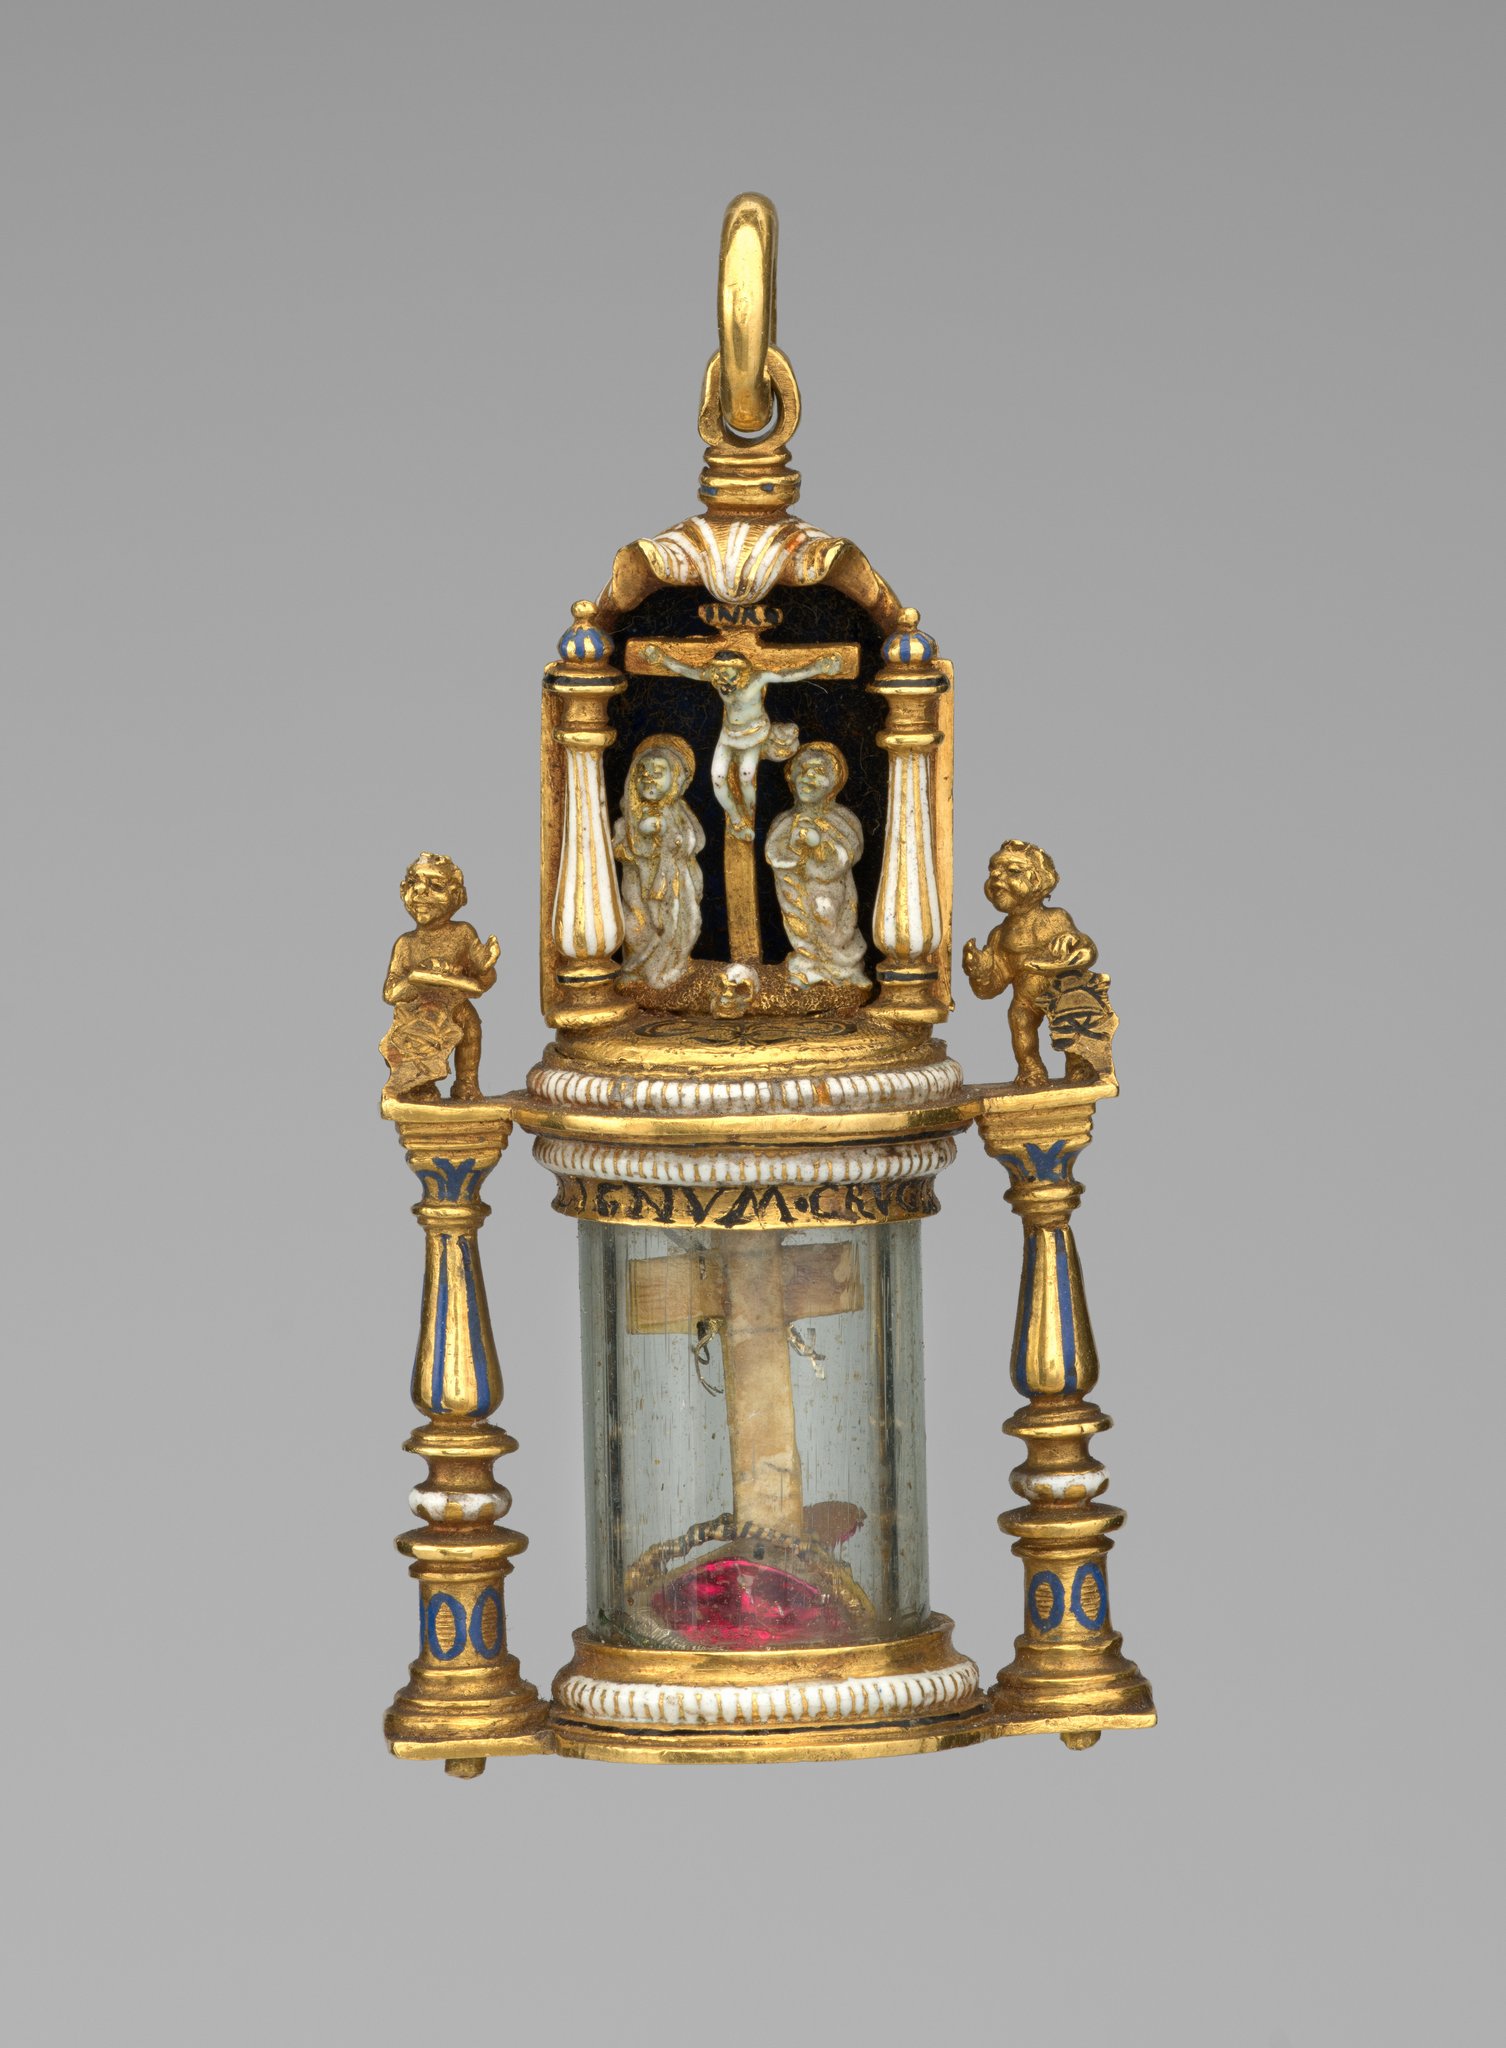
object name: reliquary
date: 1501-1600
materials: enamel, gold, quartz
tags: jesus,reliquaries,crucifixion